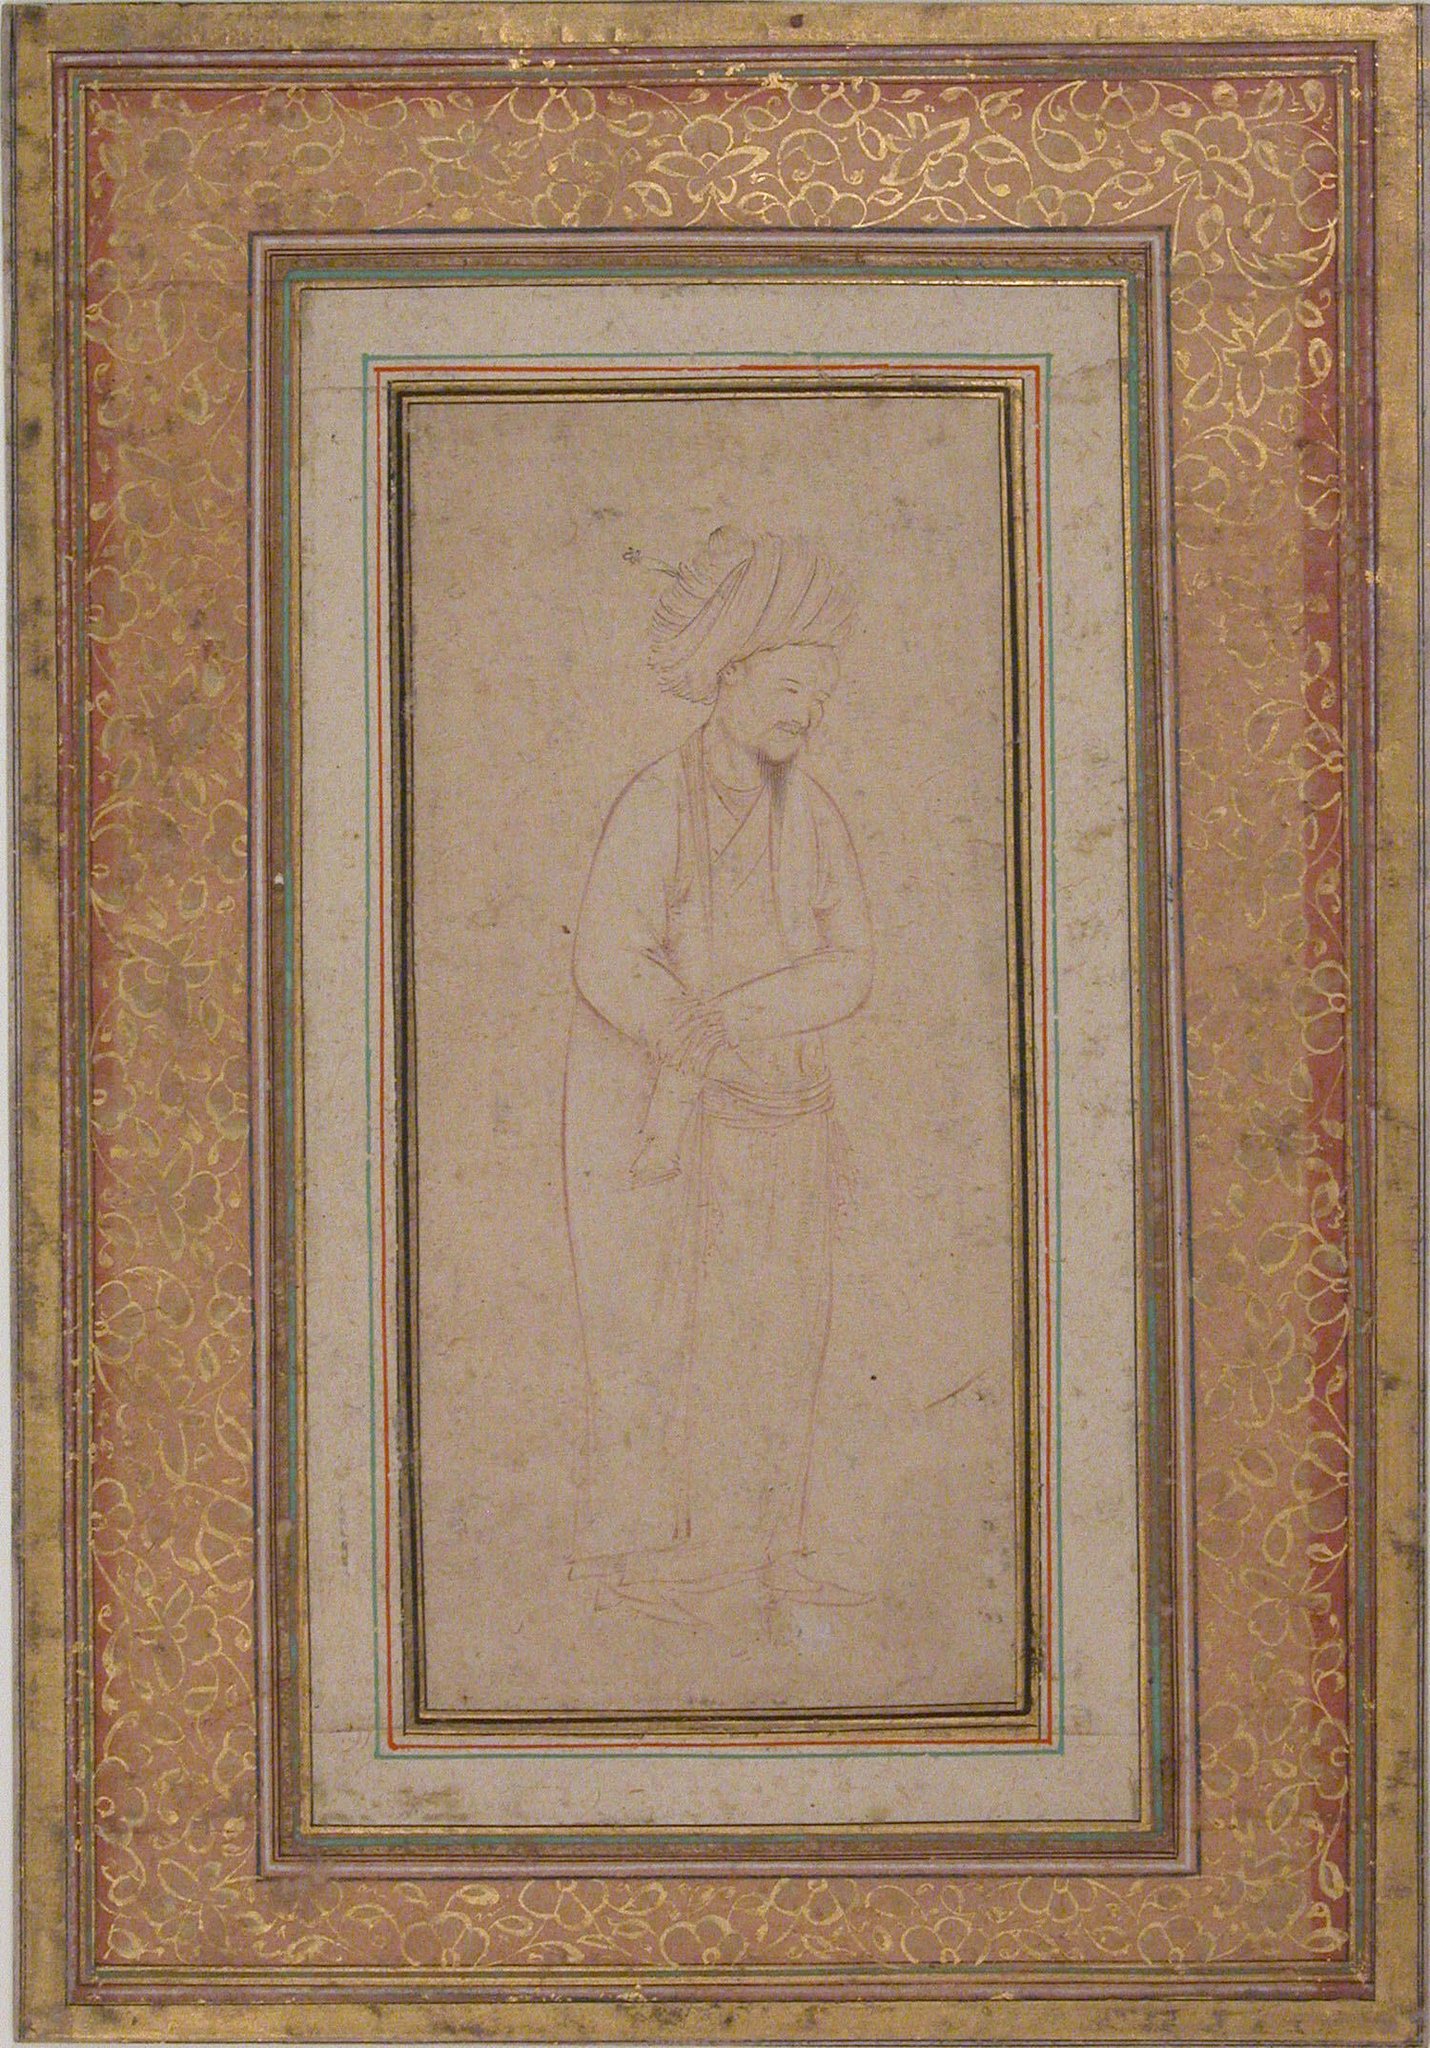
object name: illustrated single work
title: Man in a Long-sleeved Coat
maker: riza-yi 'abbasi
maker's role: artist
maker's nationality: iranian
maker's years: 1540-1660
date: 1598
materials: ink, paper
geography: iran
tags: men